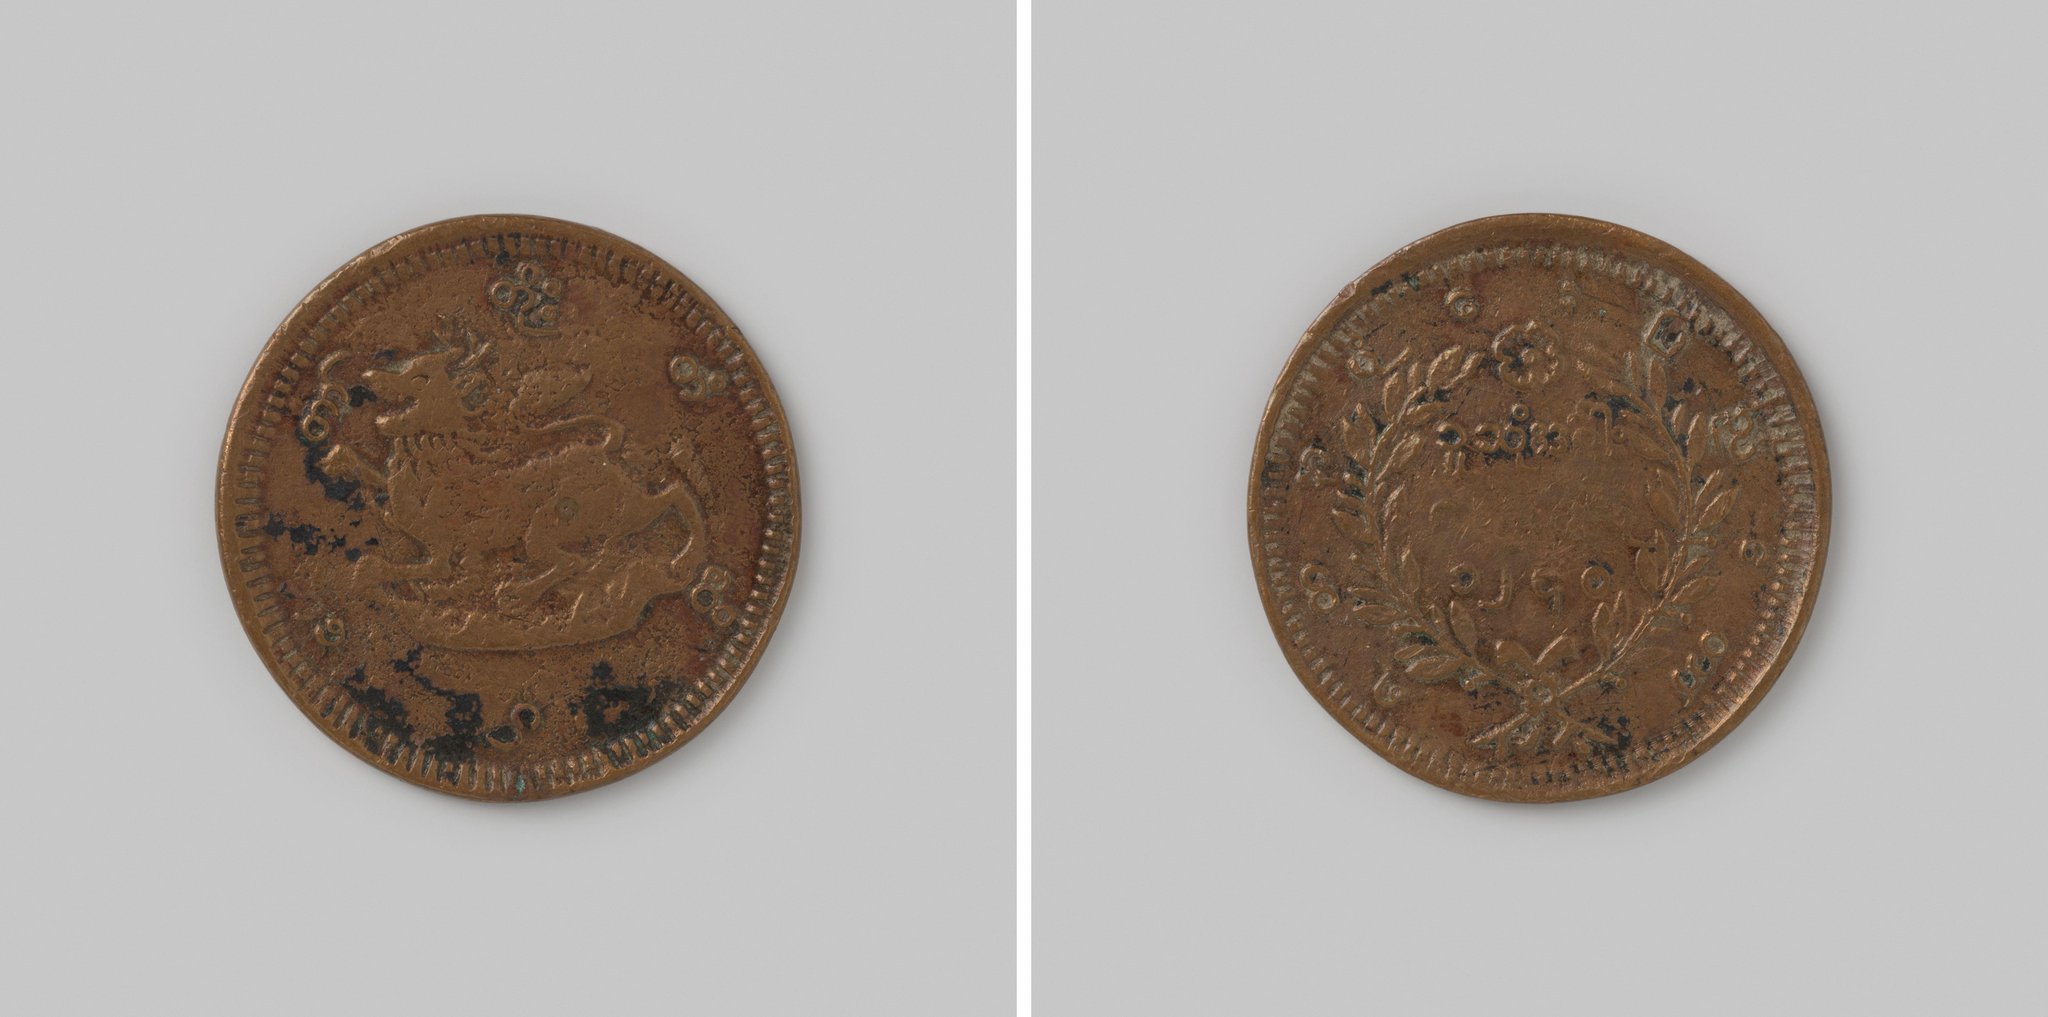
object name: coin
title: 1/4 anna of 1/4 pe uit Birma van Thibaw, 1240 [=1878]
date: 1878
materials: copper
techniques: striking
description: Koperen munt. Voorzijde: een leeuw. Keerzijde: tussen twee samengebonden takken waarde-aanduiding in twee regels, waaronder jaartal:1240. Gladde lrand.